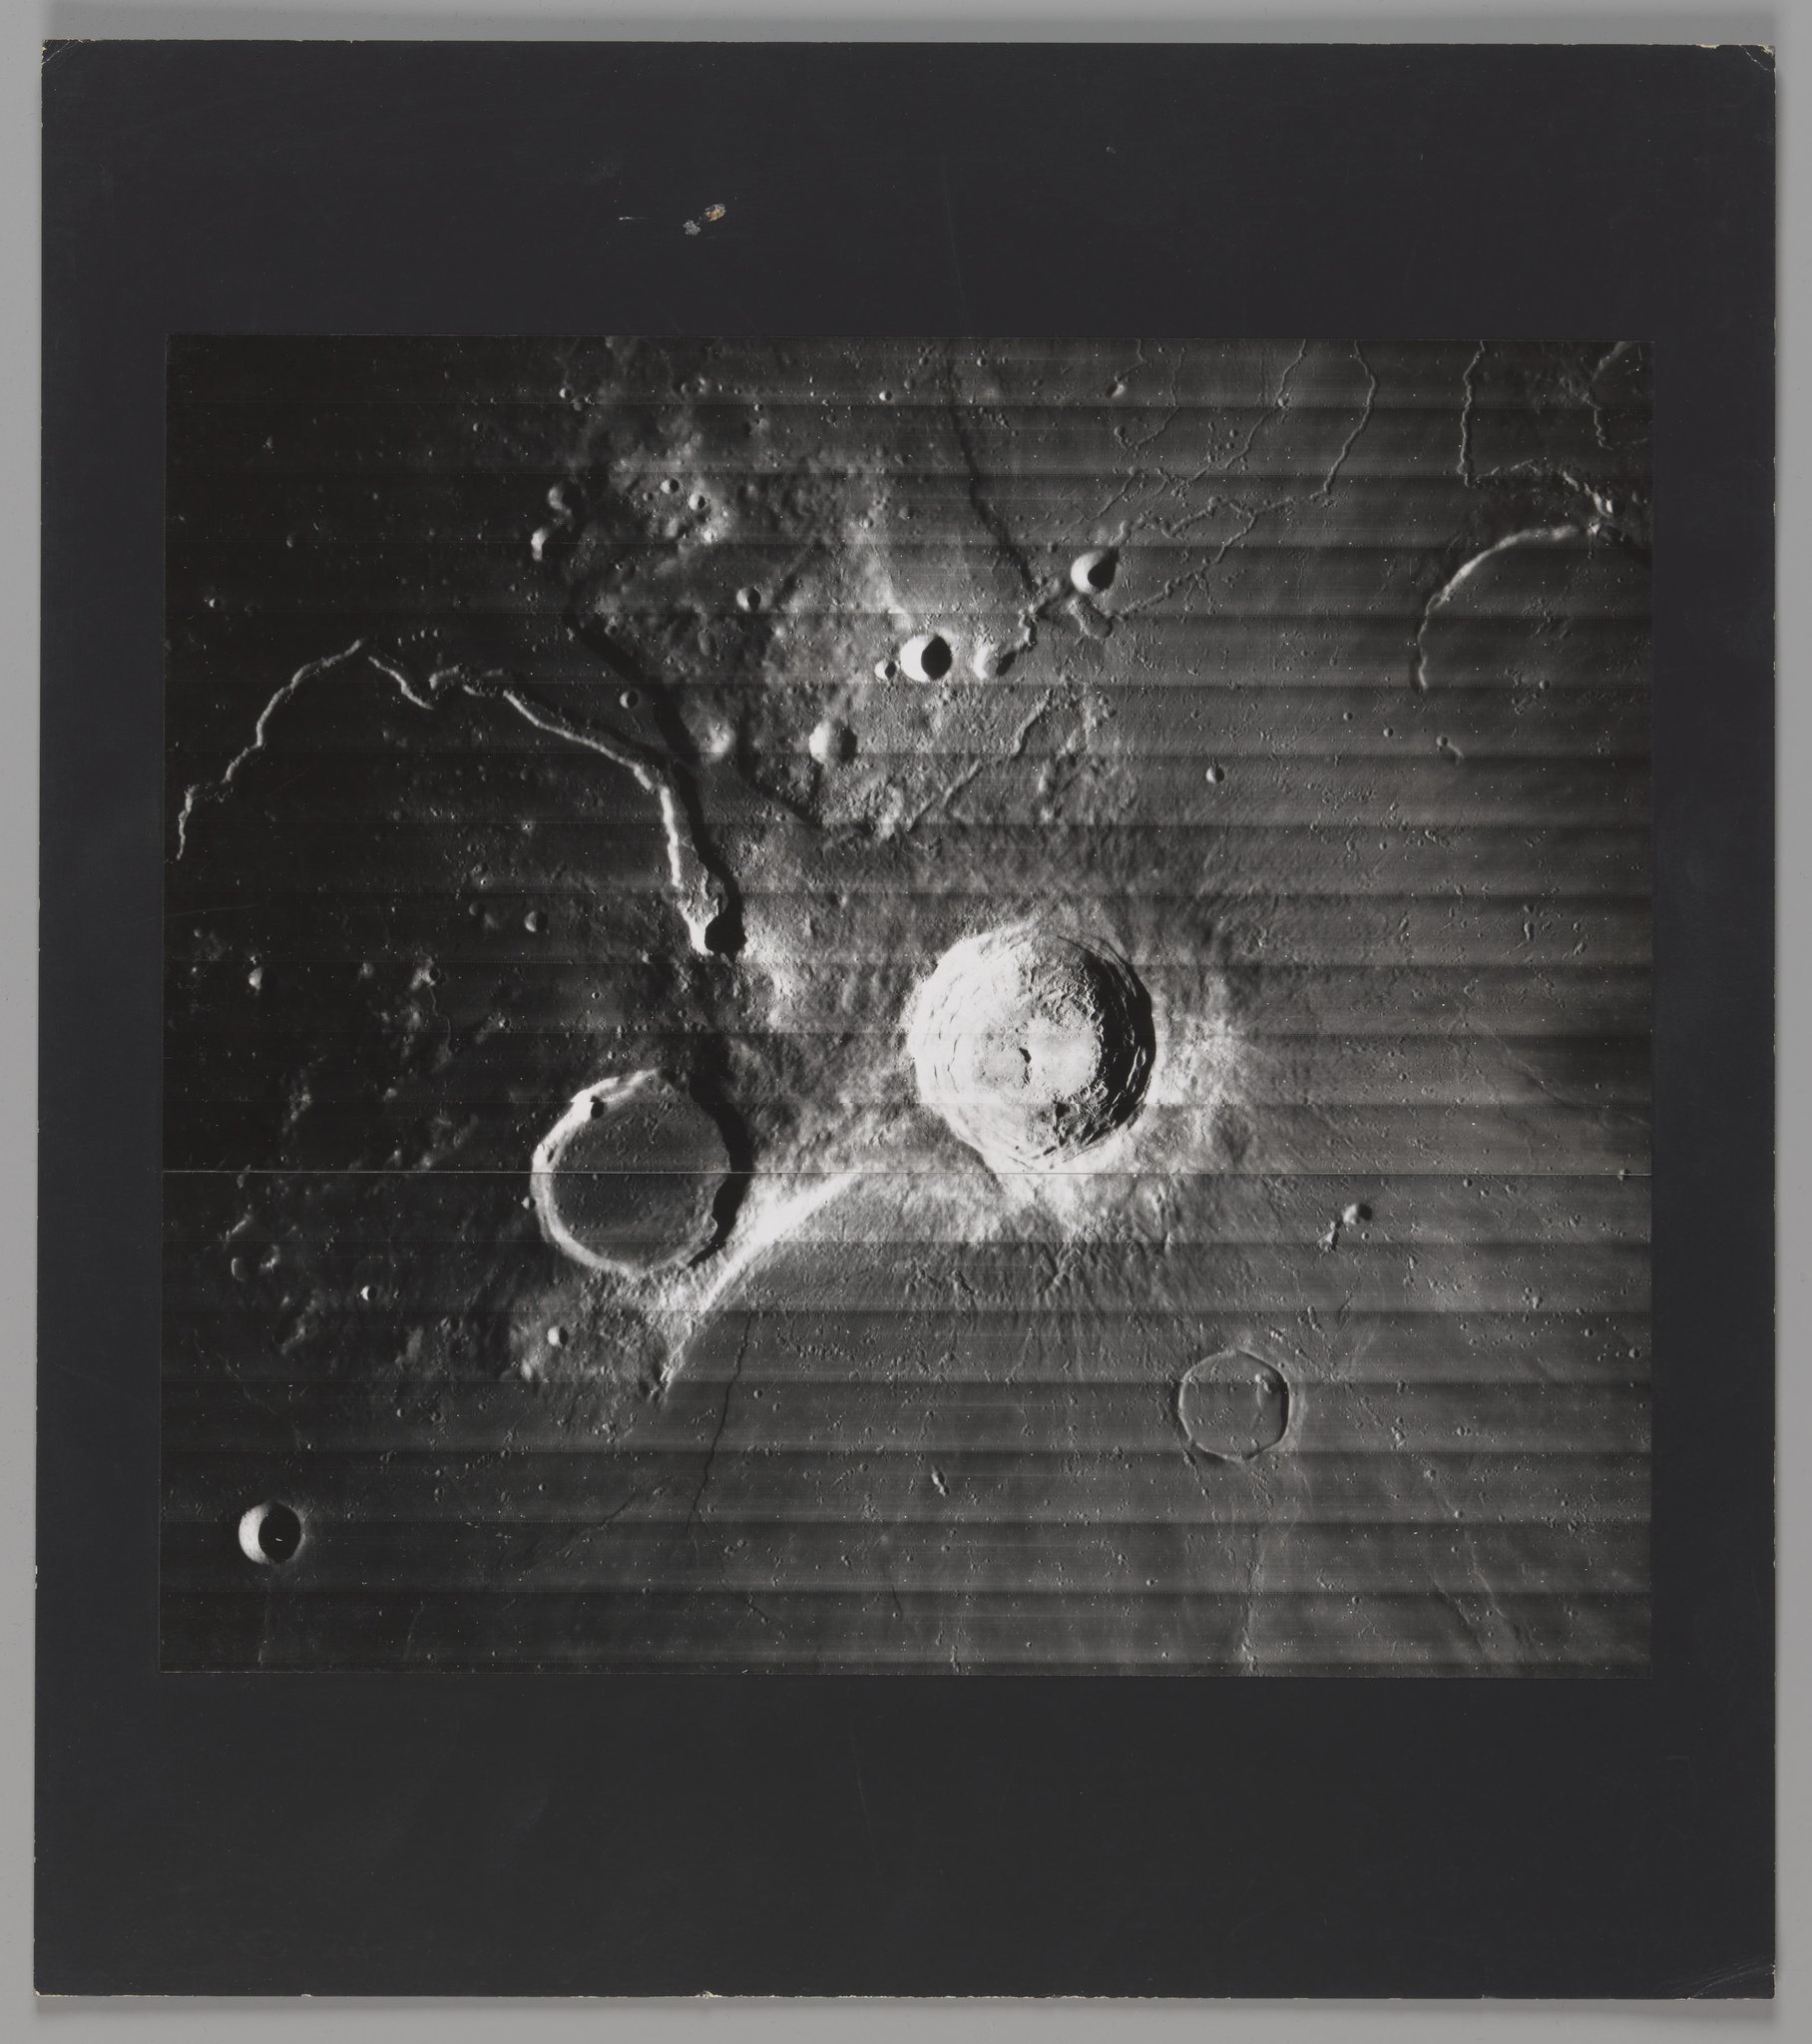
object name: photograph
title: Crater Aristarchus, Schroter's Valley, and Vicinity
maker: national aeronautics and space administration (nasa)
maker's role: artist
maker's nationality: american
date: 1967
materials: photographic print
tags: moon,astronomy